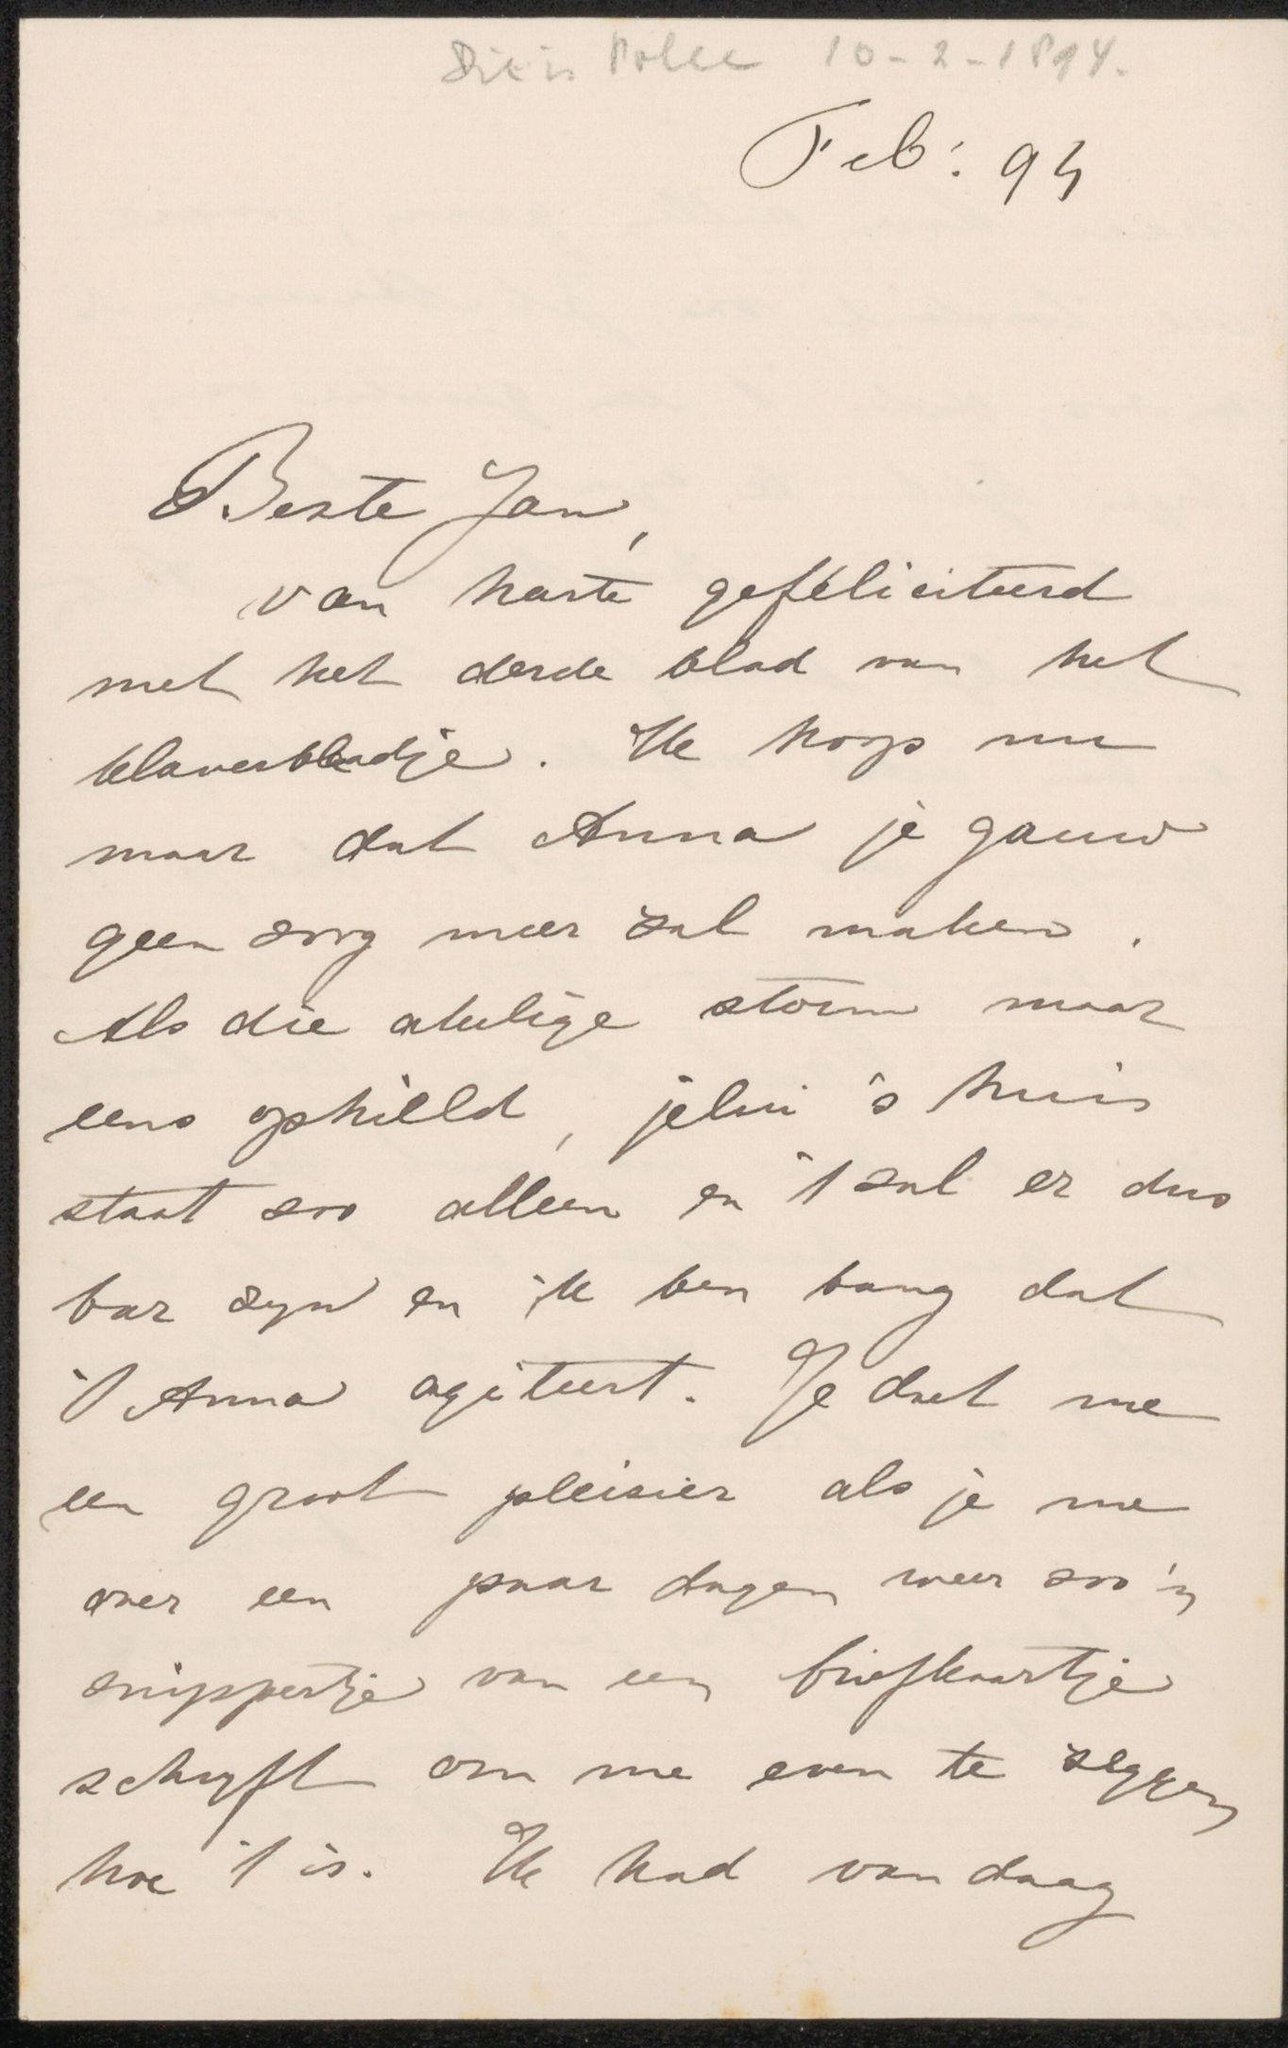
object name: letter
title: Brief aan Jan Veth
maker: wally moes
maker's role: draughtsman, print maker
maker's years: 1856-1918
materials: ink, paper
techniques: pen, writing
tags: dordrecht, jan veth, arnhem, painter, anton mauve, artist, anna dorothea dirks, draughtsman, ariette sophia jeannette mauve-carbentus, family life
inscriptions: collector's mark: ‘RPK’